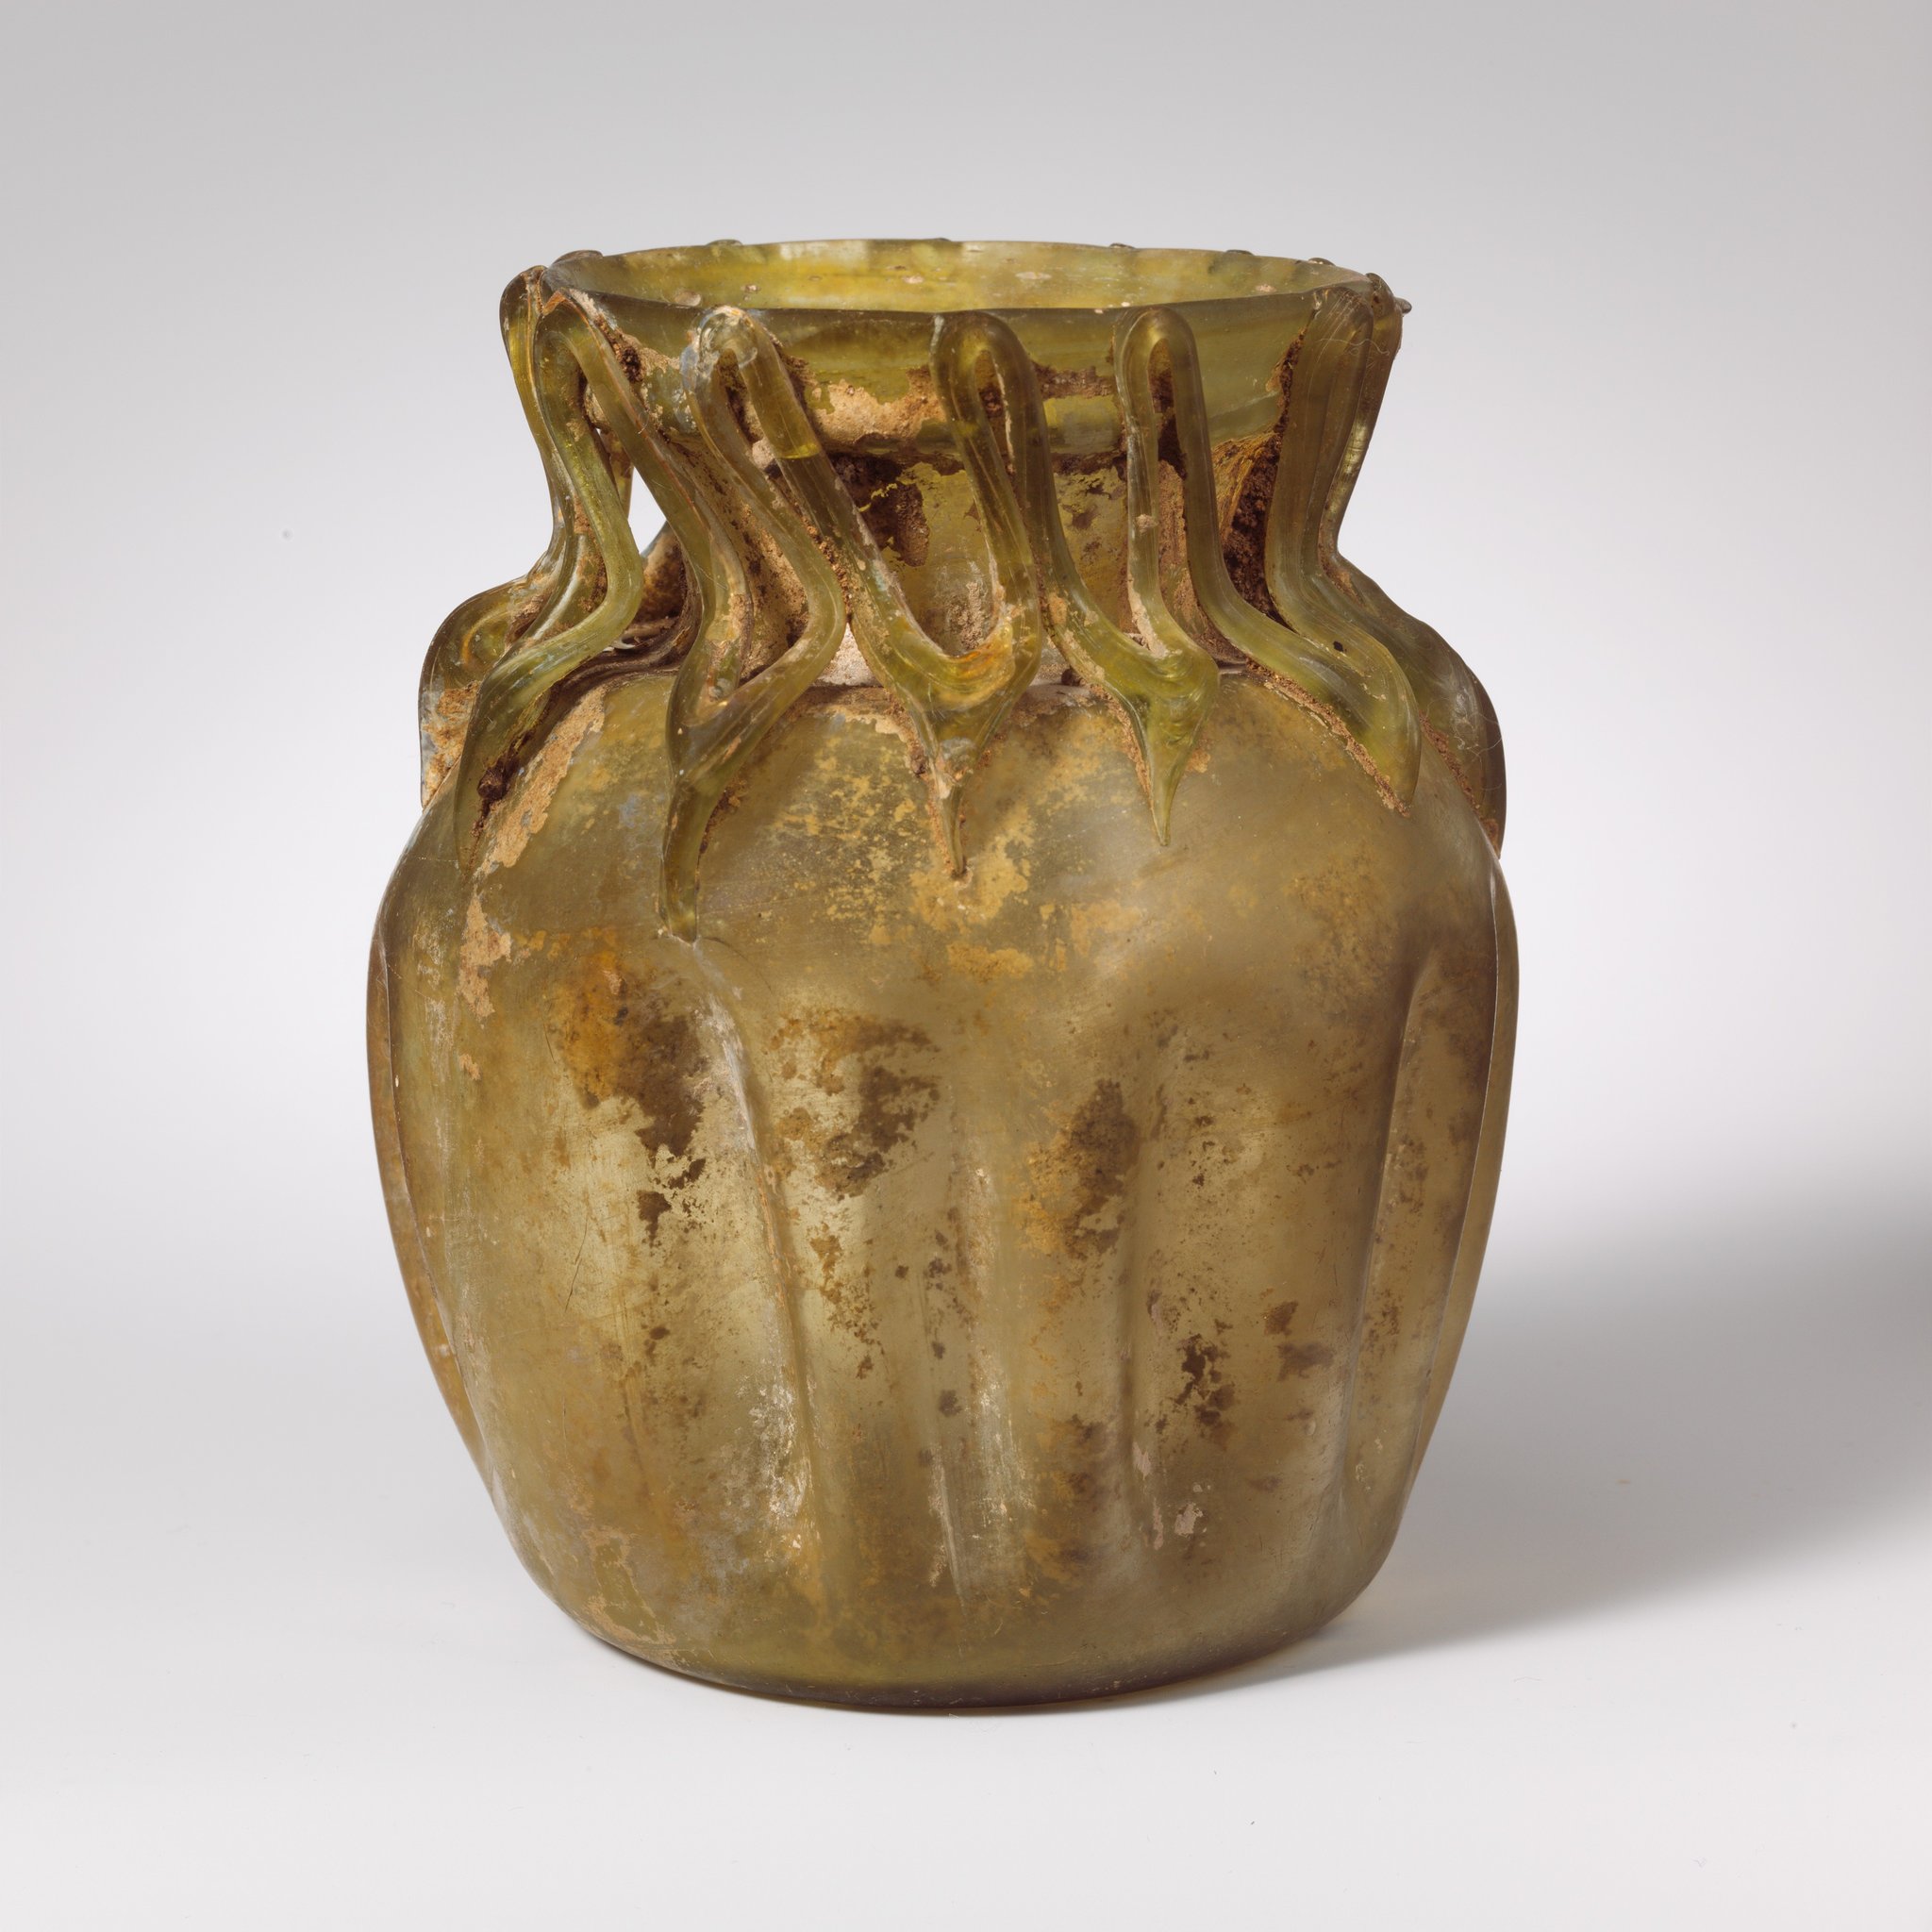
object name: jar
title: Glass jar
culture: roman, syrian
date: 301-400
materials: glass